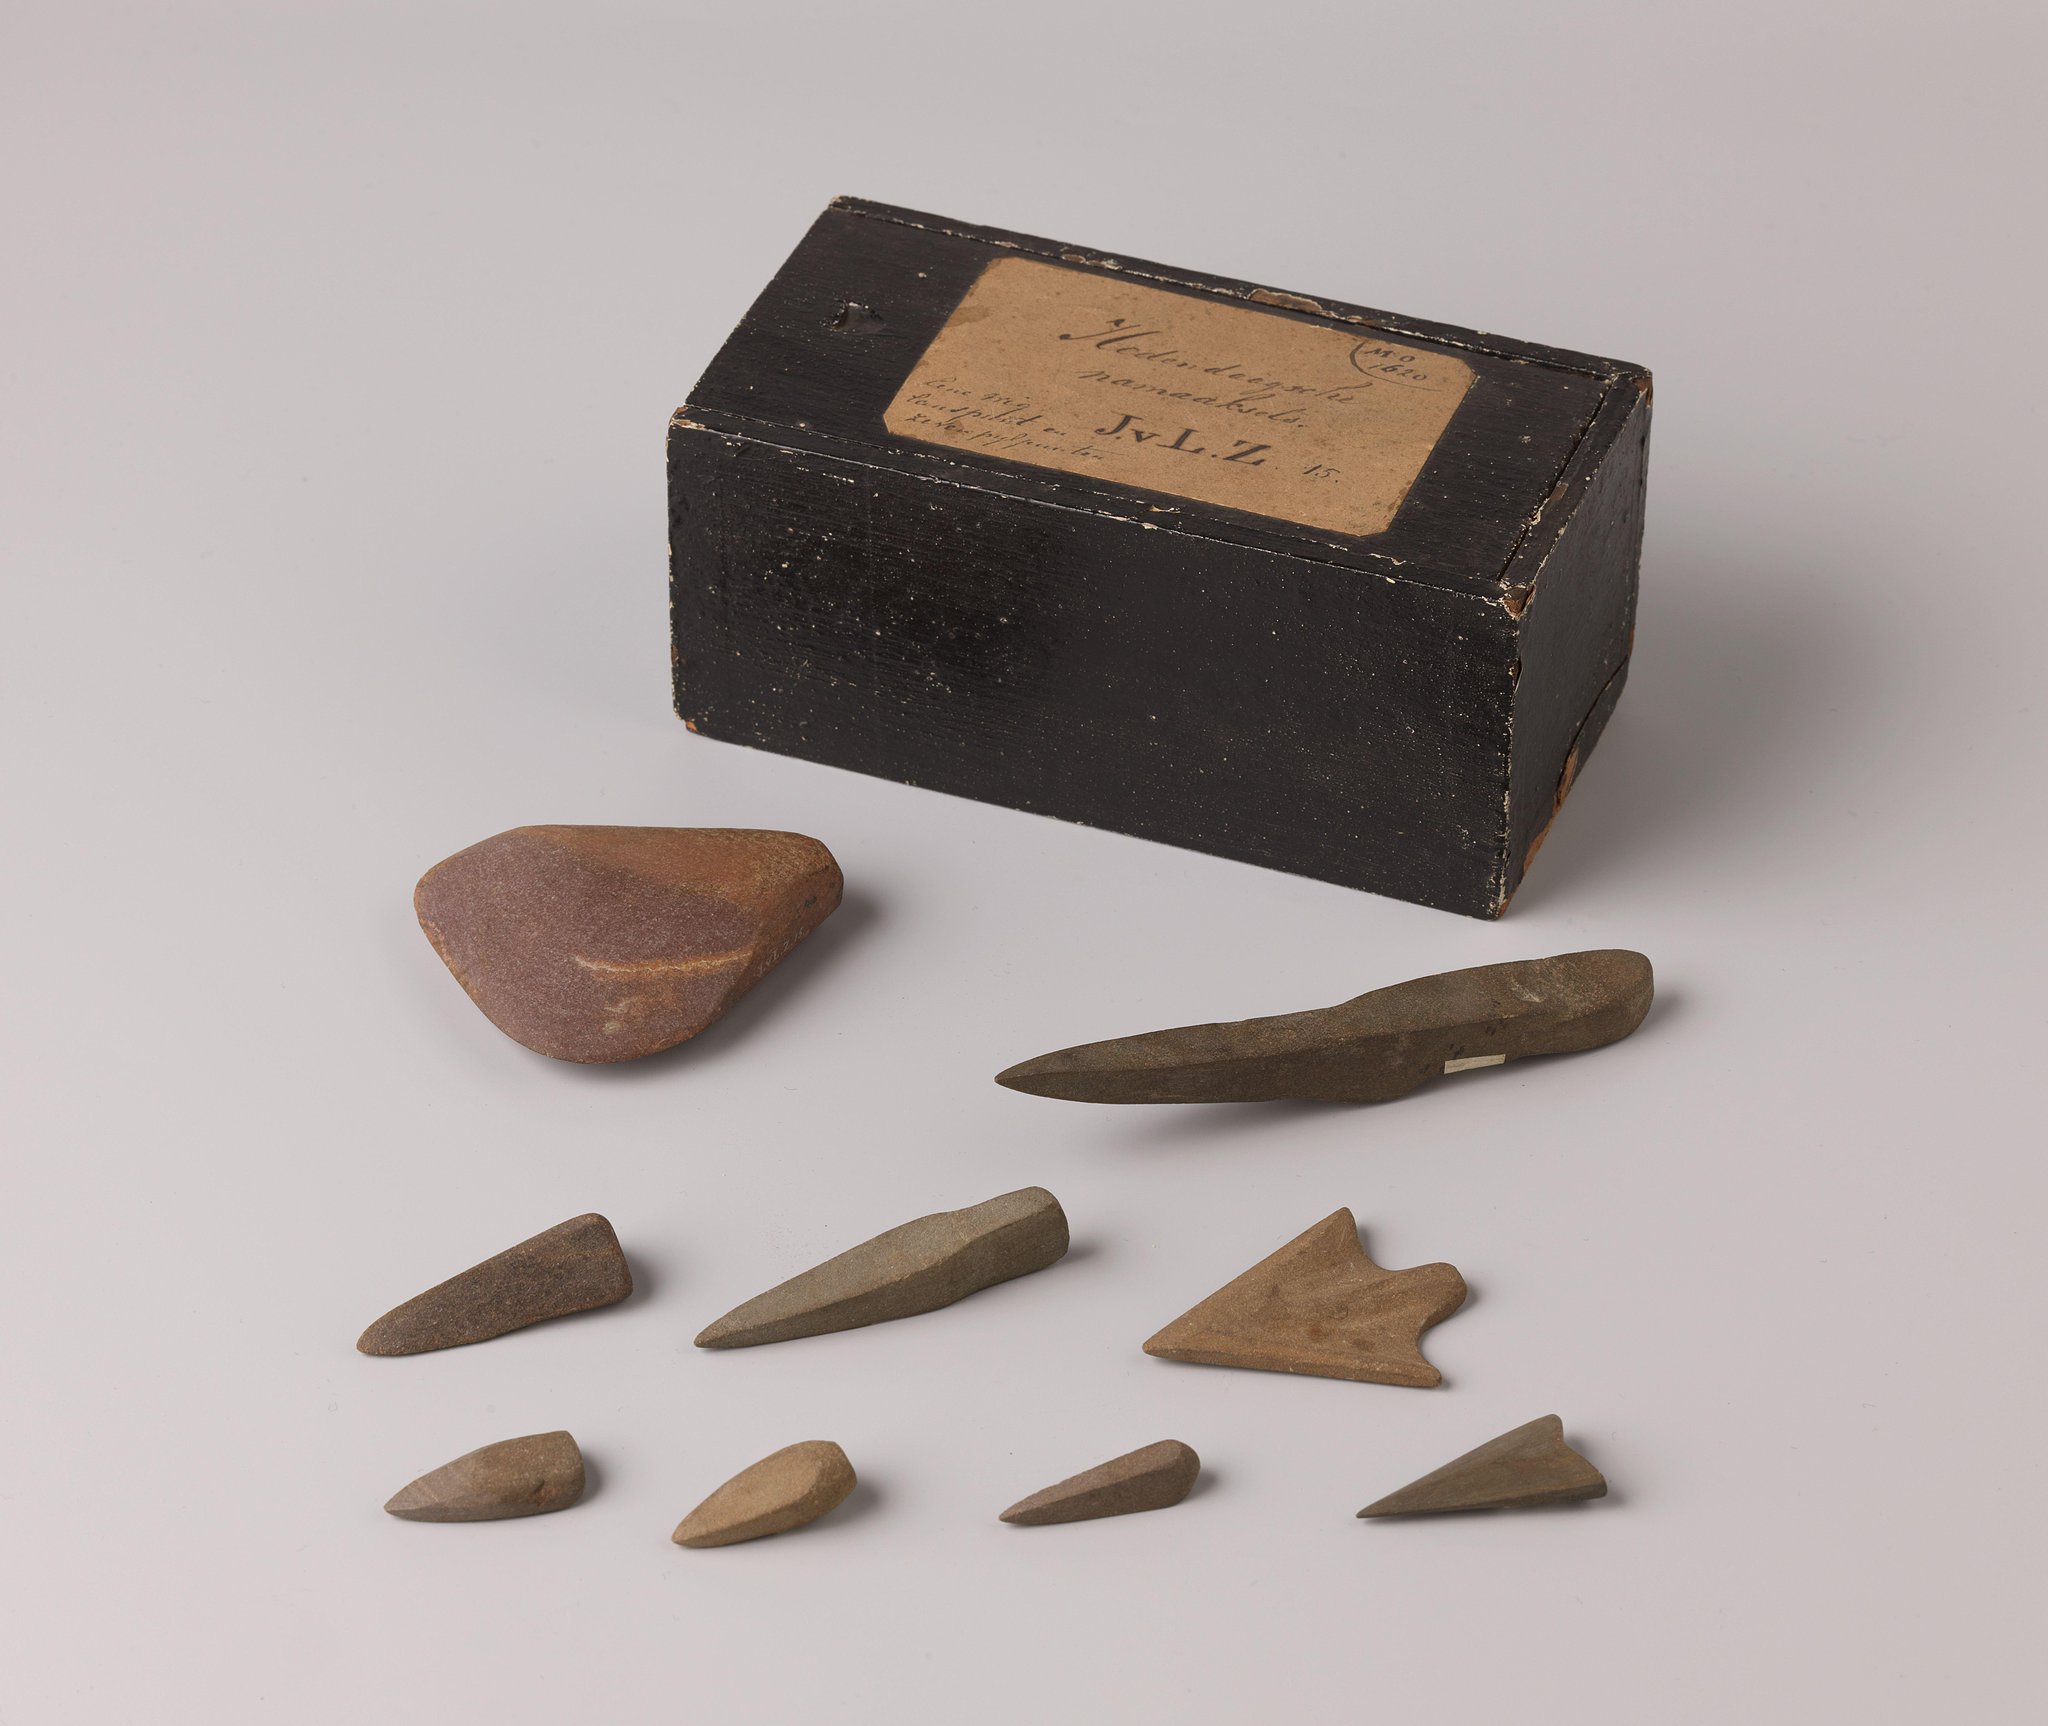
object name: chest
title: Hedendaagsche namaaksels: een wig, een lanspunt en zeven pijlpunten; in houten doos met schuifdeksel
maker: j.h. van lennip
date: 1840-1852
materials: ink, paper, wood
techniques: grinding, painting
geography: zeist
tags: haarlemmermeer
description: Houten doosje met schuifdeksel, zwart geverfd, met op de deksel een etiket geplakt. In het doosje zitten negen stenen voorwerpen: zes kleinere pijlpunten, één langwerpige en één driehoekige lanspunt en een driehoekige wig. De voorwerpen zijn genummerd met etiketten 20-a t/m i. Daarnaast dragen ze allemaal een geschilderd nummer: J.Vl.Z15-a t/m h. J.vL.Z.15-a komt overheen met 20-b. De wig, 20-a, draagt als geschilderd nummer enkel J.vL.Z.15. Verder is de volgorde gelijklopend. Opschrift.